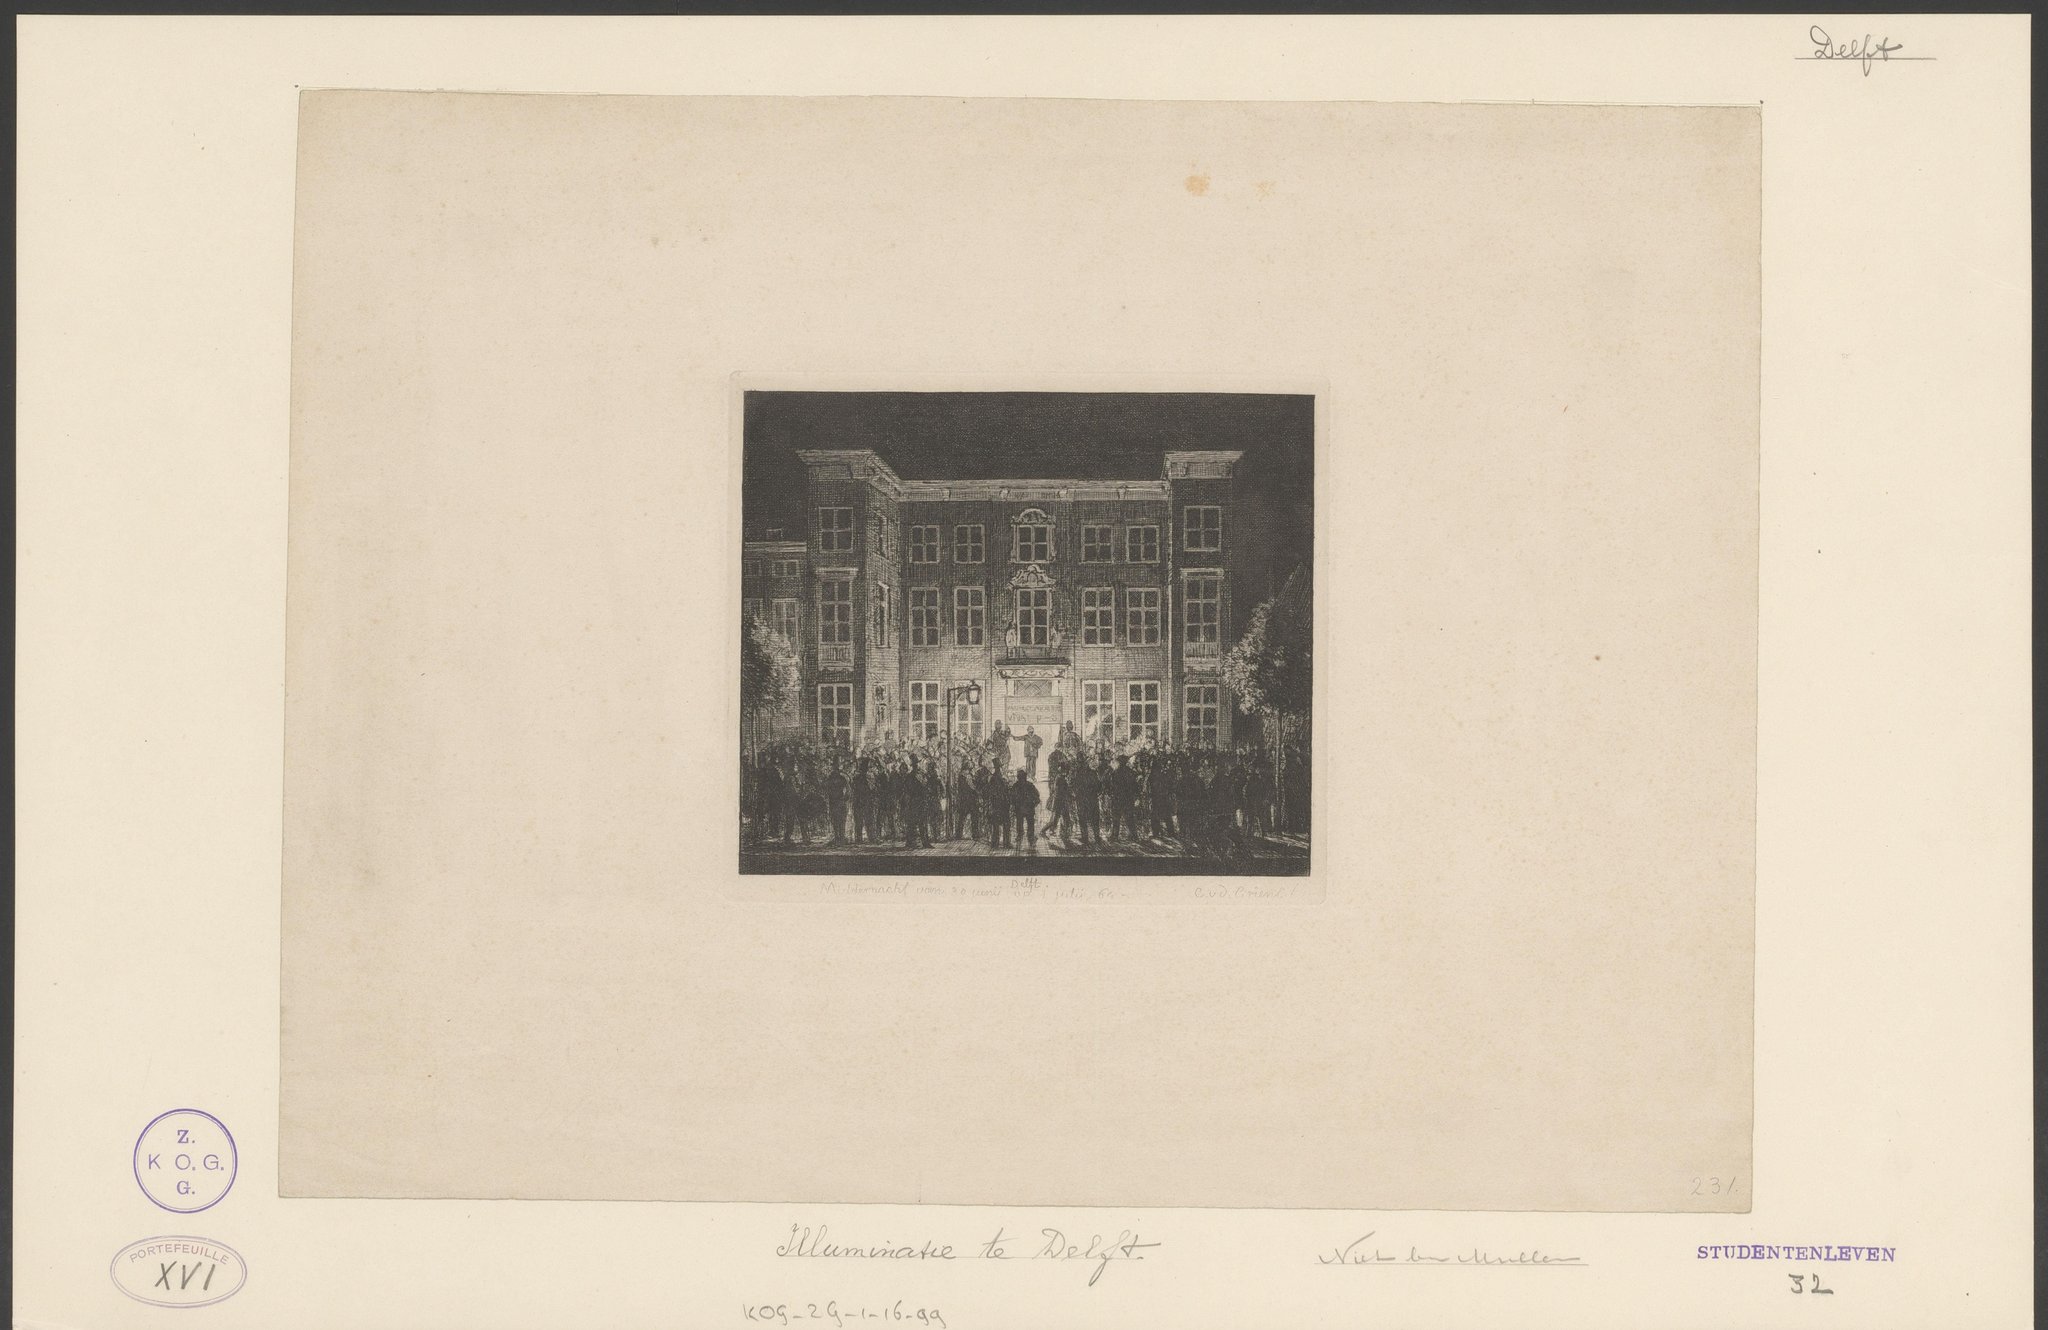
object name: print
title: Delft, Middernacht van 30 junii 61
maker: cornelis van der griendt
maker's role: draughtsman, painter, print maker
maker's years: 1827-1918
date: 1864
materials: paper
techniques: drypoint, etching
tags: university, festivities (+ illumination, fire-works ~ festive activities), student life, delft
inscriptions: collector's mark: Lugt 1641, stamp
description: Illuminatie van een huis te Delft, middernacht van 30 juni op 1 juli 1864. Een groep studenten verzameld voor een verlicht huis aan een gracht. Boven de deur van het huis een bord met het opschrift 'Akademia VIVAT P - S'. Bij de naamsverandering van de Delftsche Akademie in de Delftsche Polytechnische School. Onderwerpsrubrieken binnen de Atlas Zeden en Gewoonten: Onderwijs en Wetenschappen, Studentenleven.